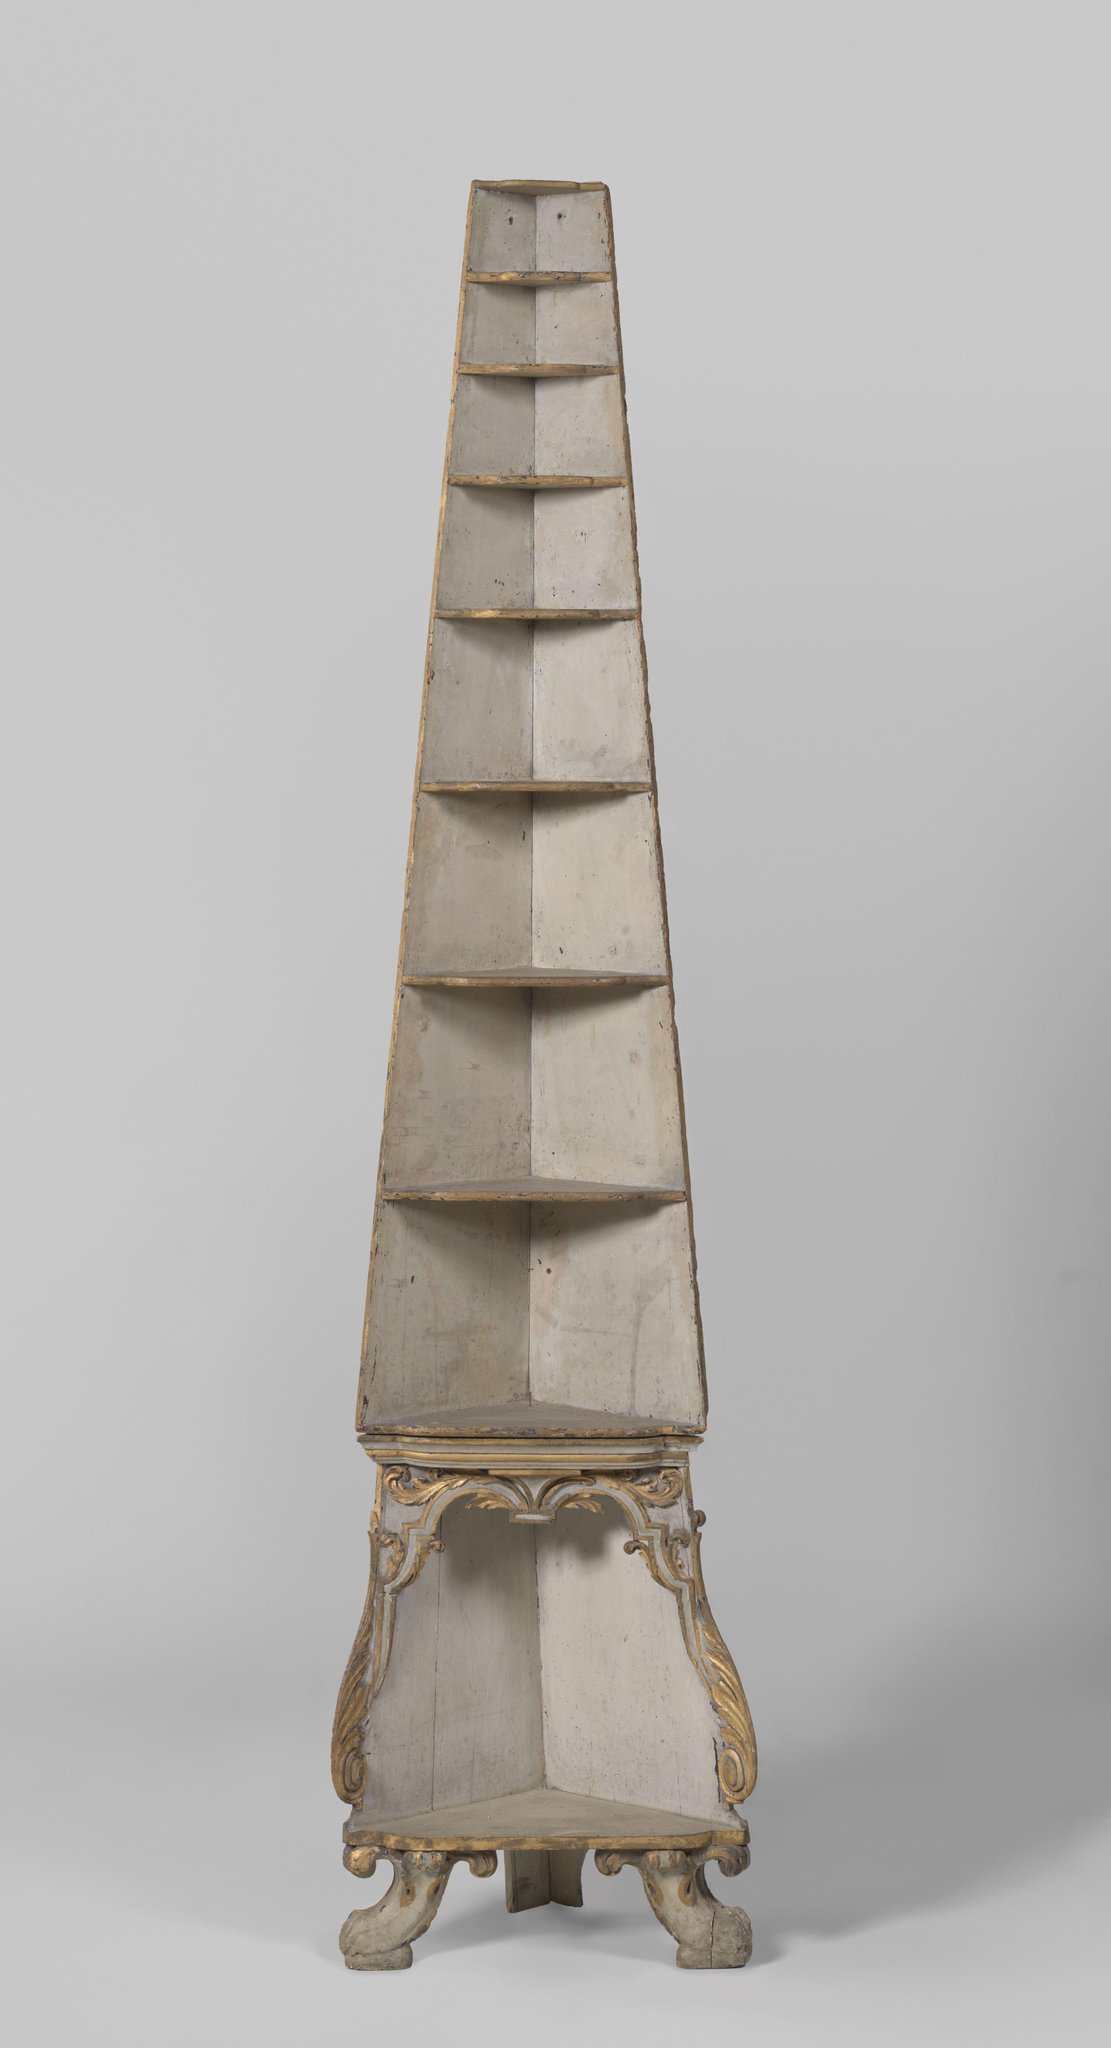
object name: furniture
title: Hoekétagère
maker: Anonymous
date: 1700-1750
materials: wood, paint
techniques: gilding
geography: netherlands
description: Hoekétagère van, wit geschilderd, eikenhout. De voorkant der boorden is verguld. De étagère loopt pyramidaal toe; het onderste vak heeft een dubbele boog en versiering van gestoken Lodewijk XIV-ornament. Pendant van BK-16727-A.